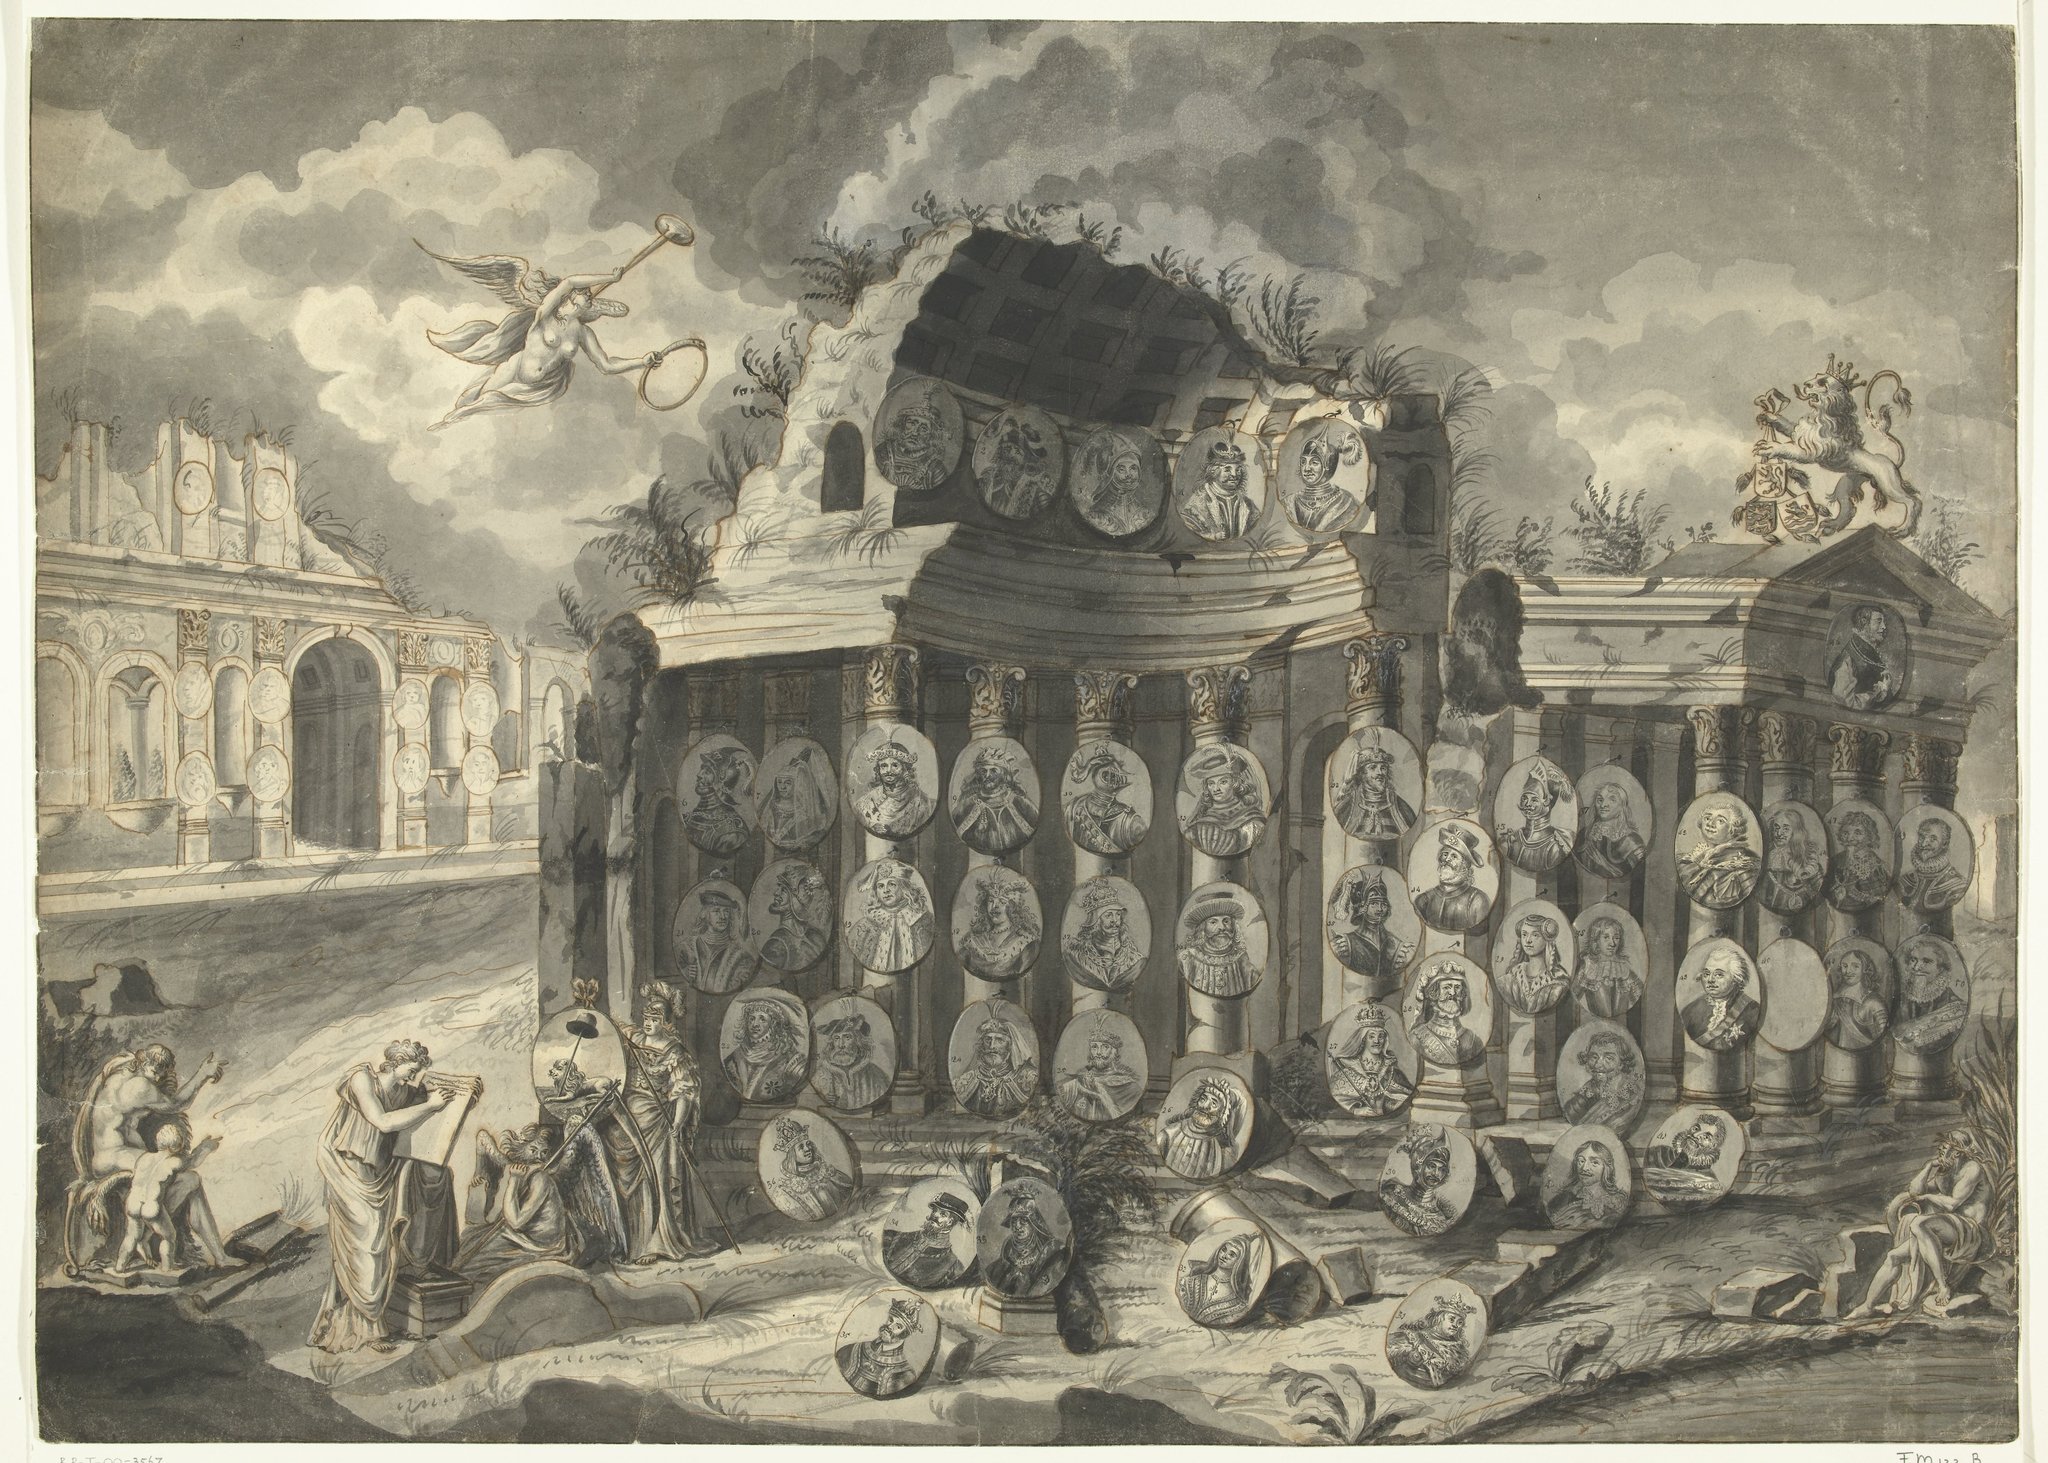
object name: drawing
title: Monument ter nagedachtenis aan de vorsten die Nederland hebben geregeerd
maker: Anonymous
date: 1700-1799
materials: ink, paper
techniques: brush, pen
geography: netherlands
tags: personifications of countries, nations, states, districts, etc., ruler, sovereign, 'historia'; 'historia' (ripa), father time, man with wings and scythe, netherlands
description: Monument ter nagedachtenis aan alle graven, prinsen en andere vorsten die Nederland hebben geregeerd. Ruïne van een tempel waarin genummerde portretten van de vorsten hangen. Links op de voorgrond schrijft Geschiedenis, daarbij Vader Tijd en de Nederlandse Maagd met een embleem van de Nederlandse Leeuw met vrijheidshoed. Op de achterkant zijn enkele contouren en portretten doorgetrokken en gekopieerd. Bij de tekening een handschrift van drie kantjes met een verklaring van de voorstelling en een lijst van de 1-50 genummerde namen van de geportretteerden.